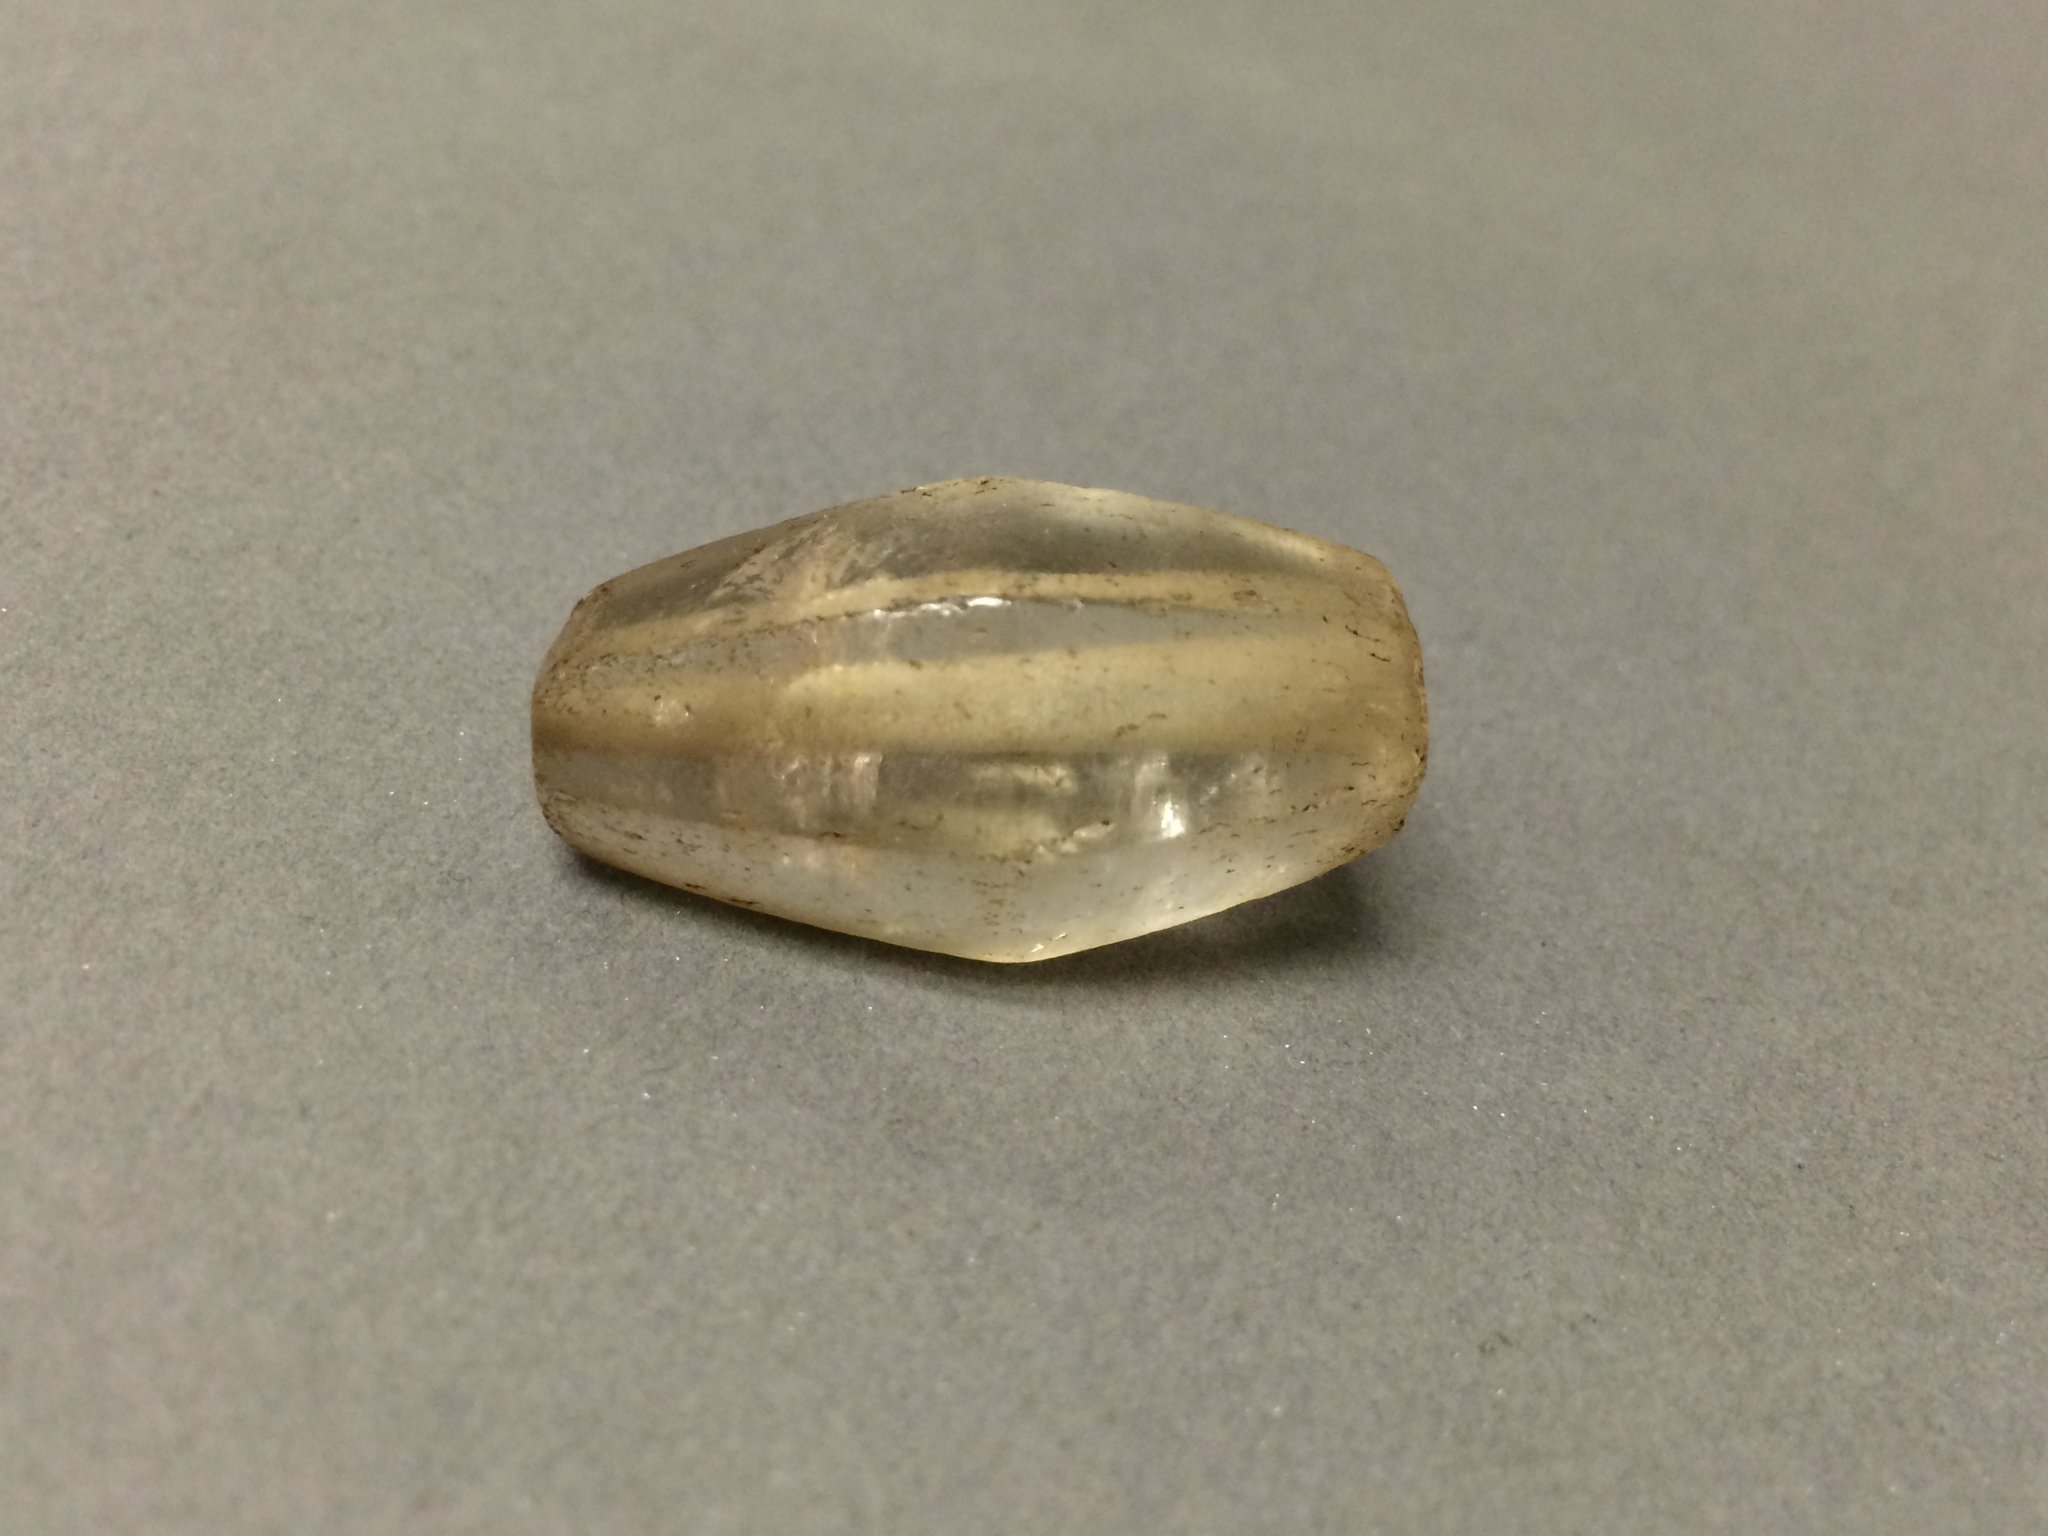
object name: bead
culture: japanese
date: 601-700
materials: crystal